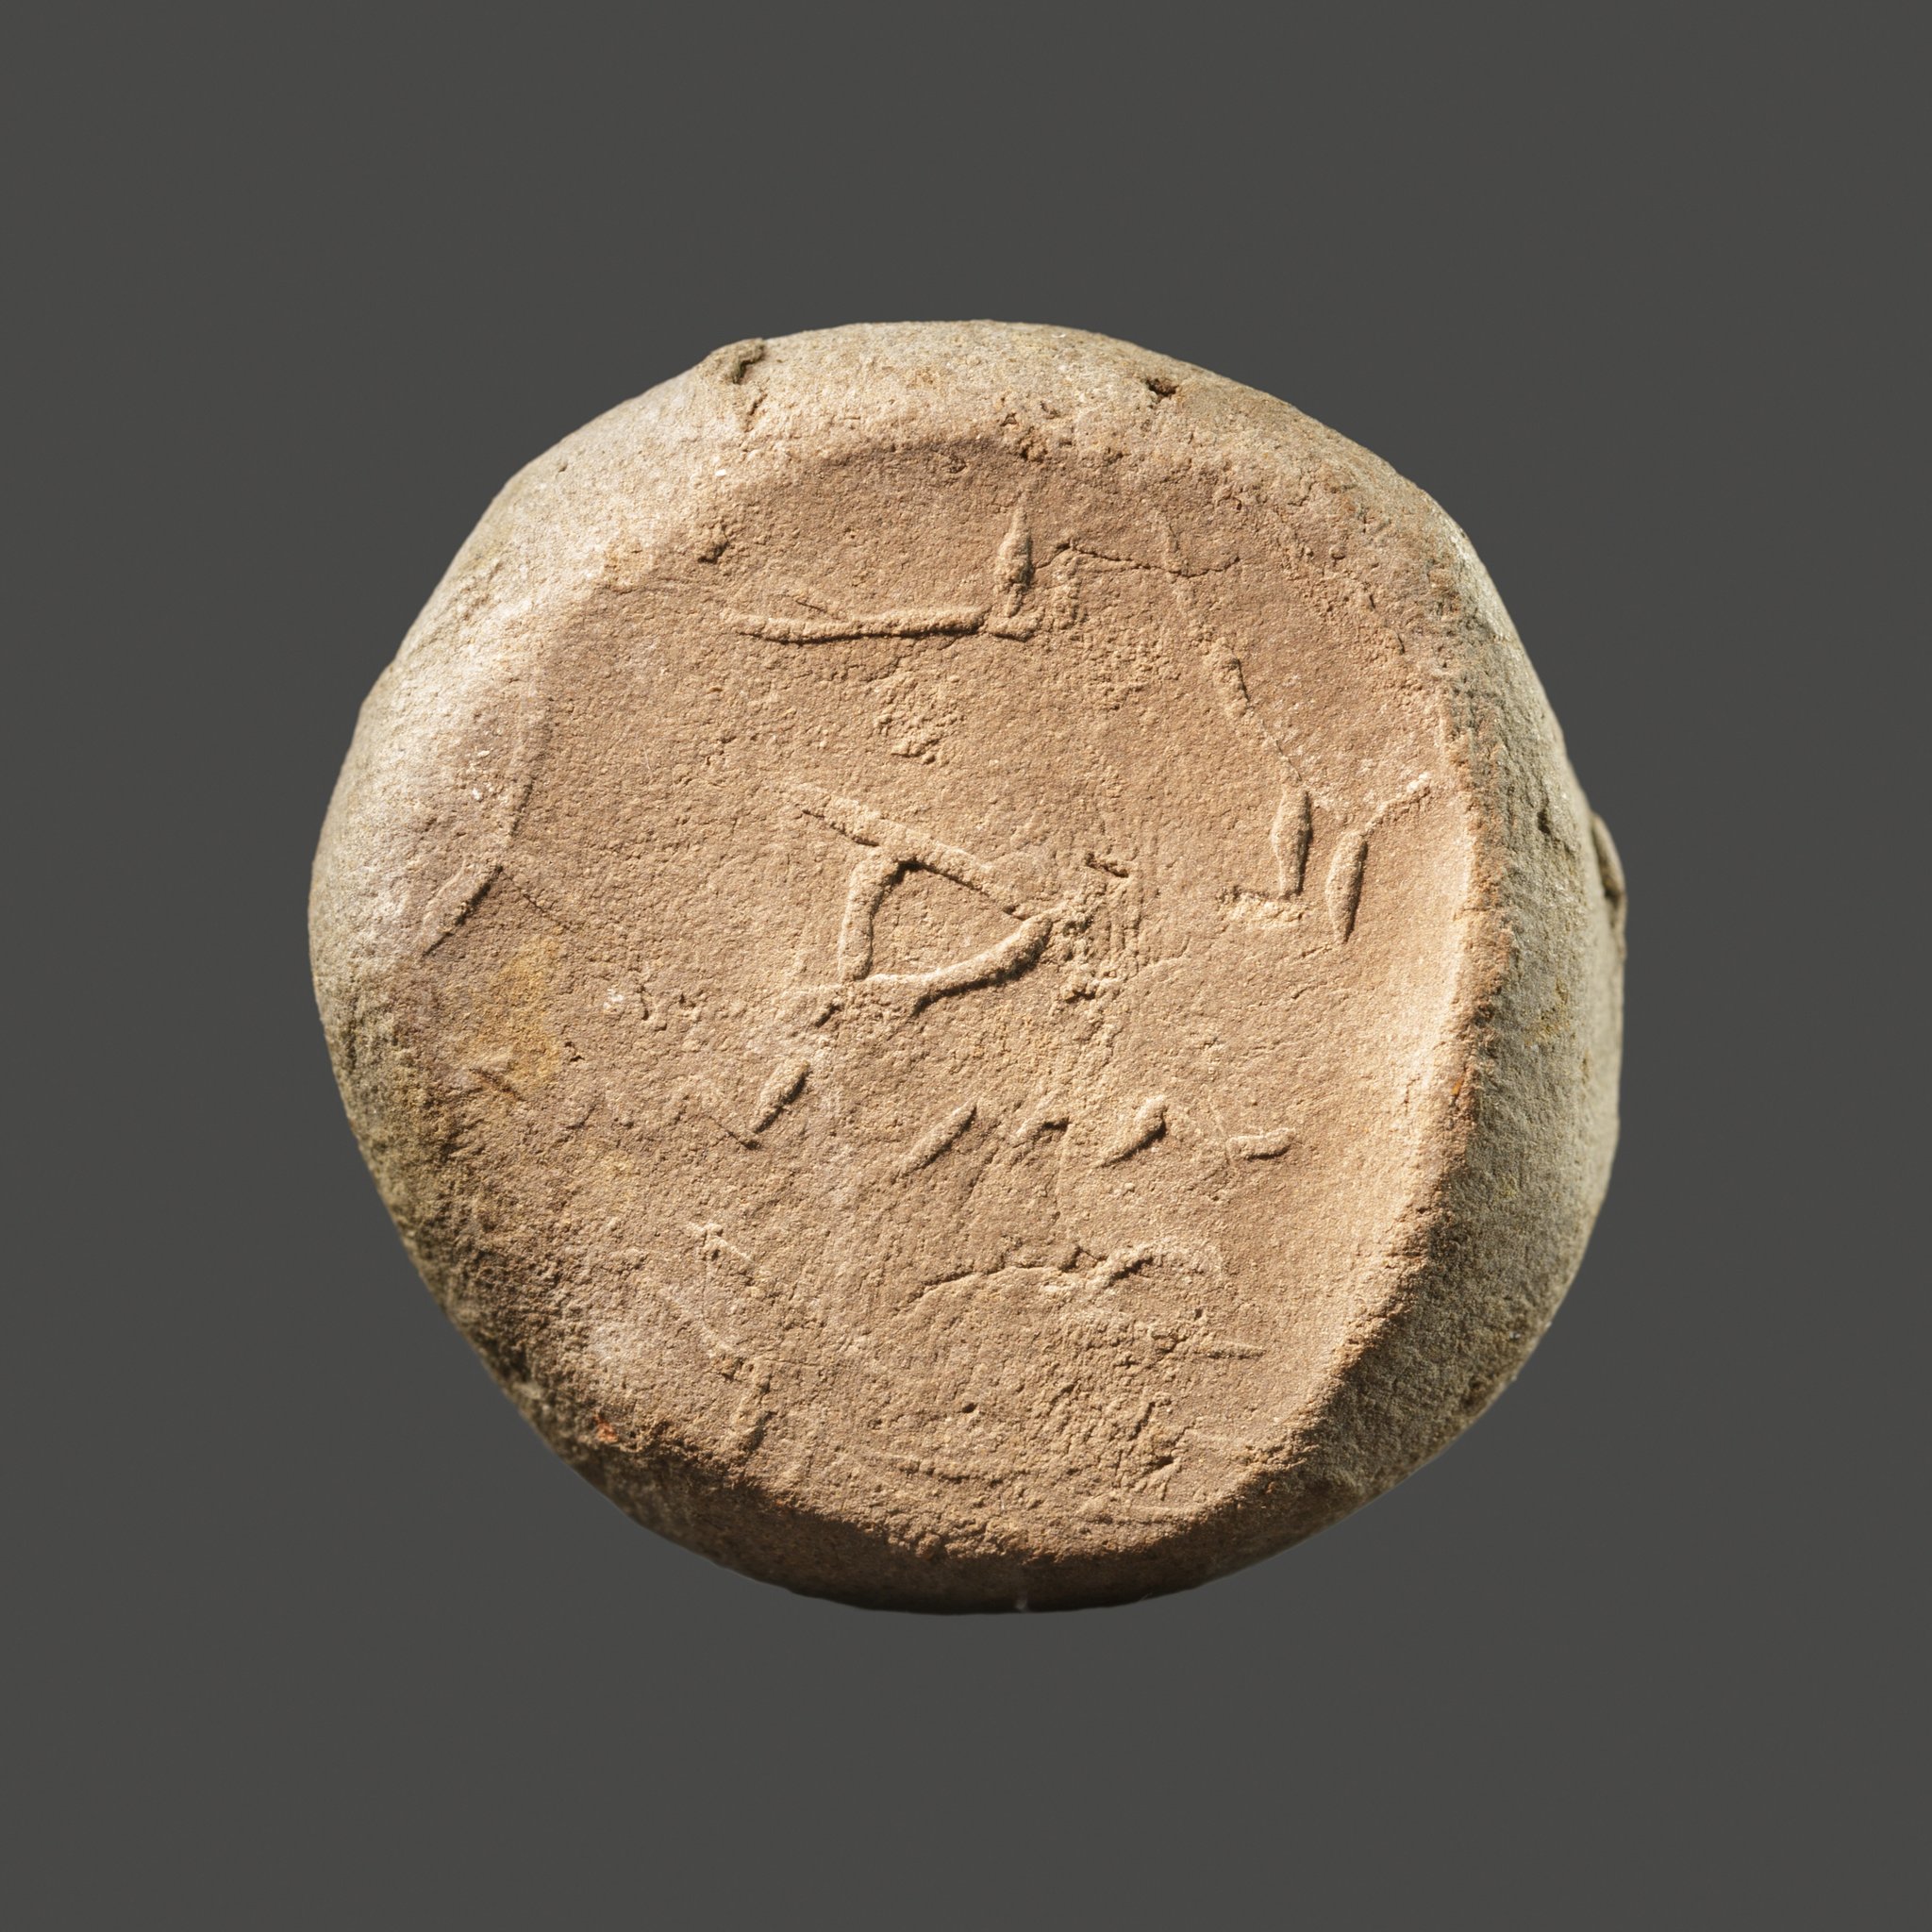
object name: reference sealing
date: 1961-1954 BCE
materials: mud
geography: egypt